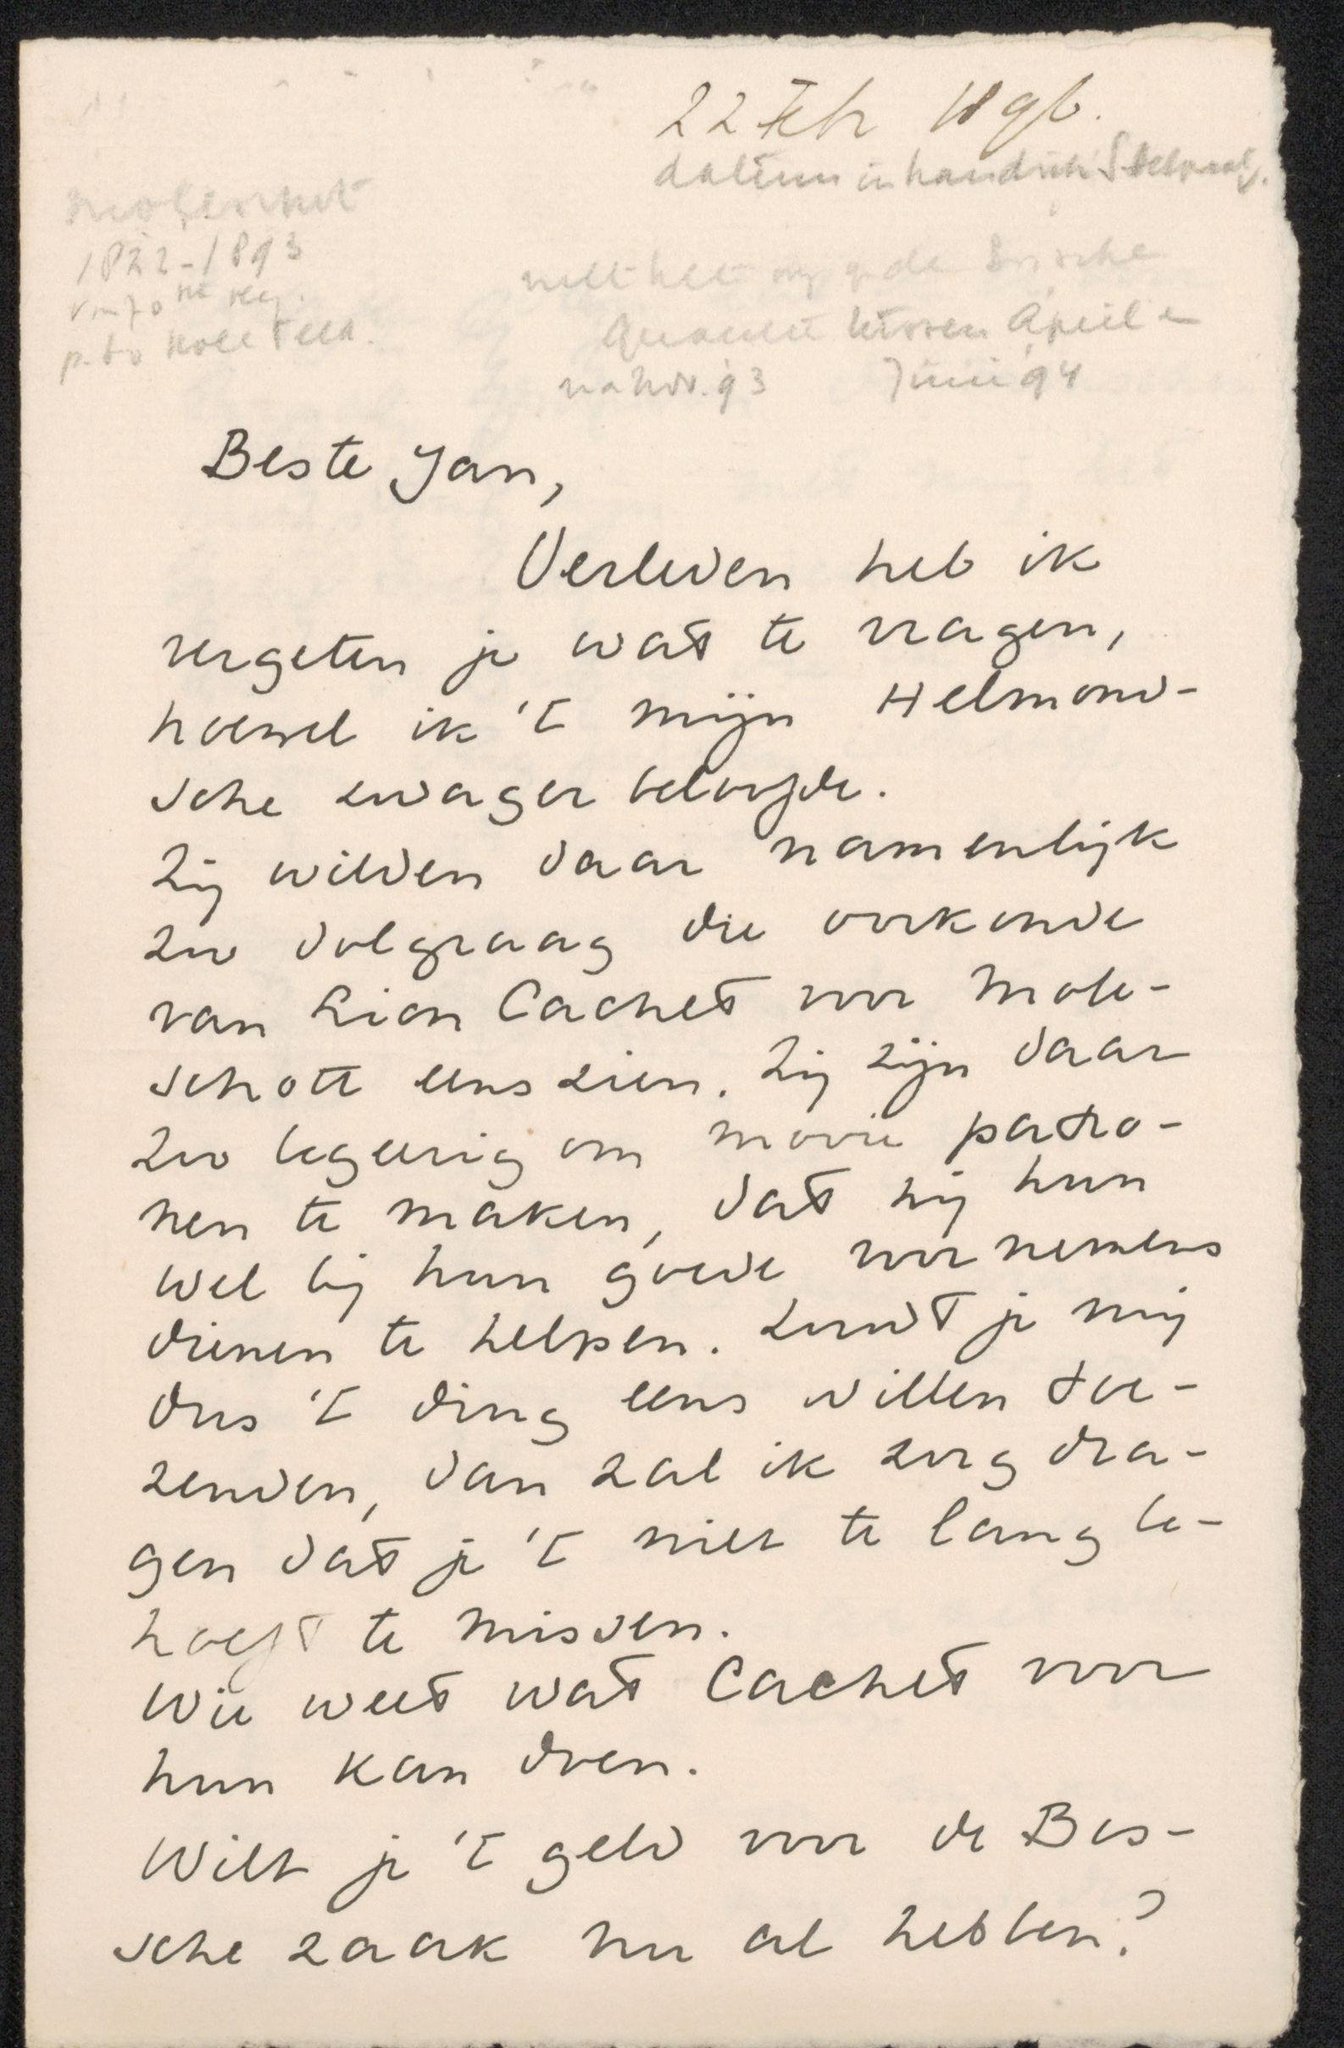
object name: letter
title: Brief aan Jan Veth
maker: richard nicolaüs roland holst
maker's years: 1868-1938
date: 1878-1925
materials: ink, paper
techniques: pen, writing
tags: dordrecht, painter, designer, jan veth, amsterdam, draughtsman, carel adolph lion cachet, andré jolles, rotterdam, money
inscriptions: watermark, collector's mark: ‘RPK’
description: Brief gedateerd 22 Febr 1896 in latere hand.